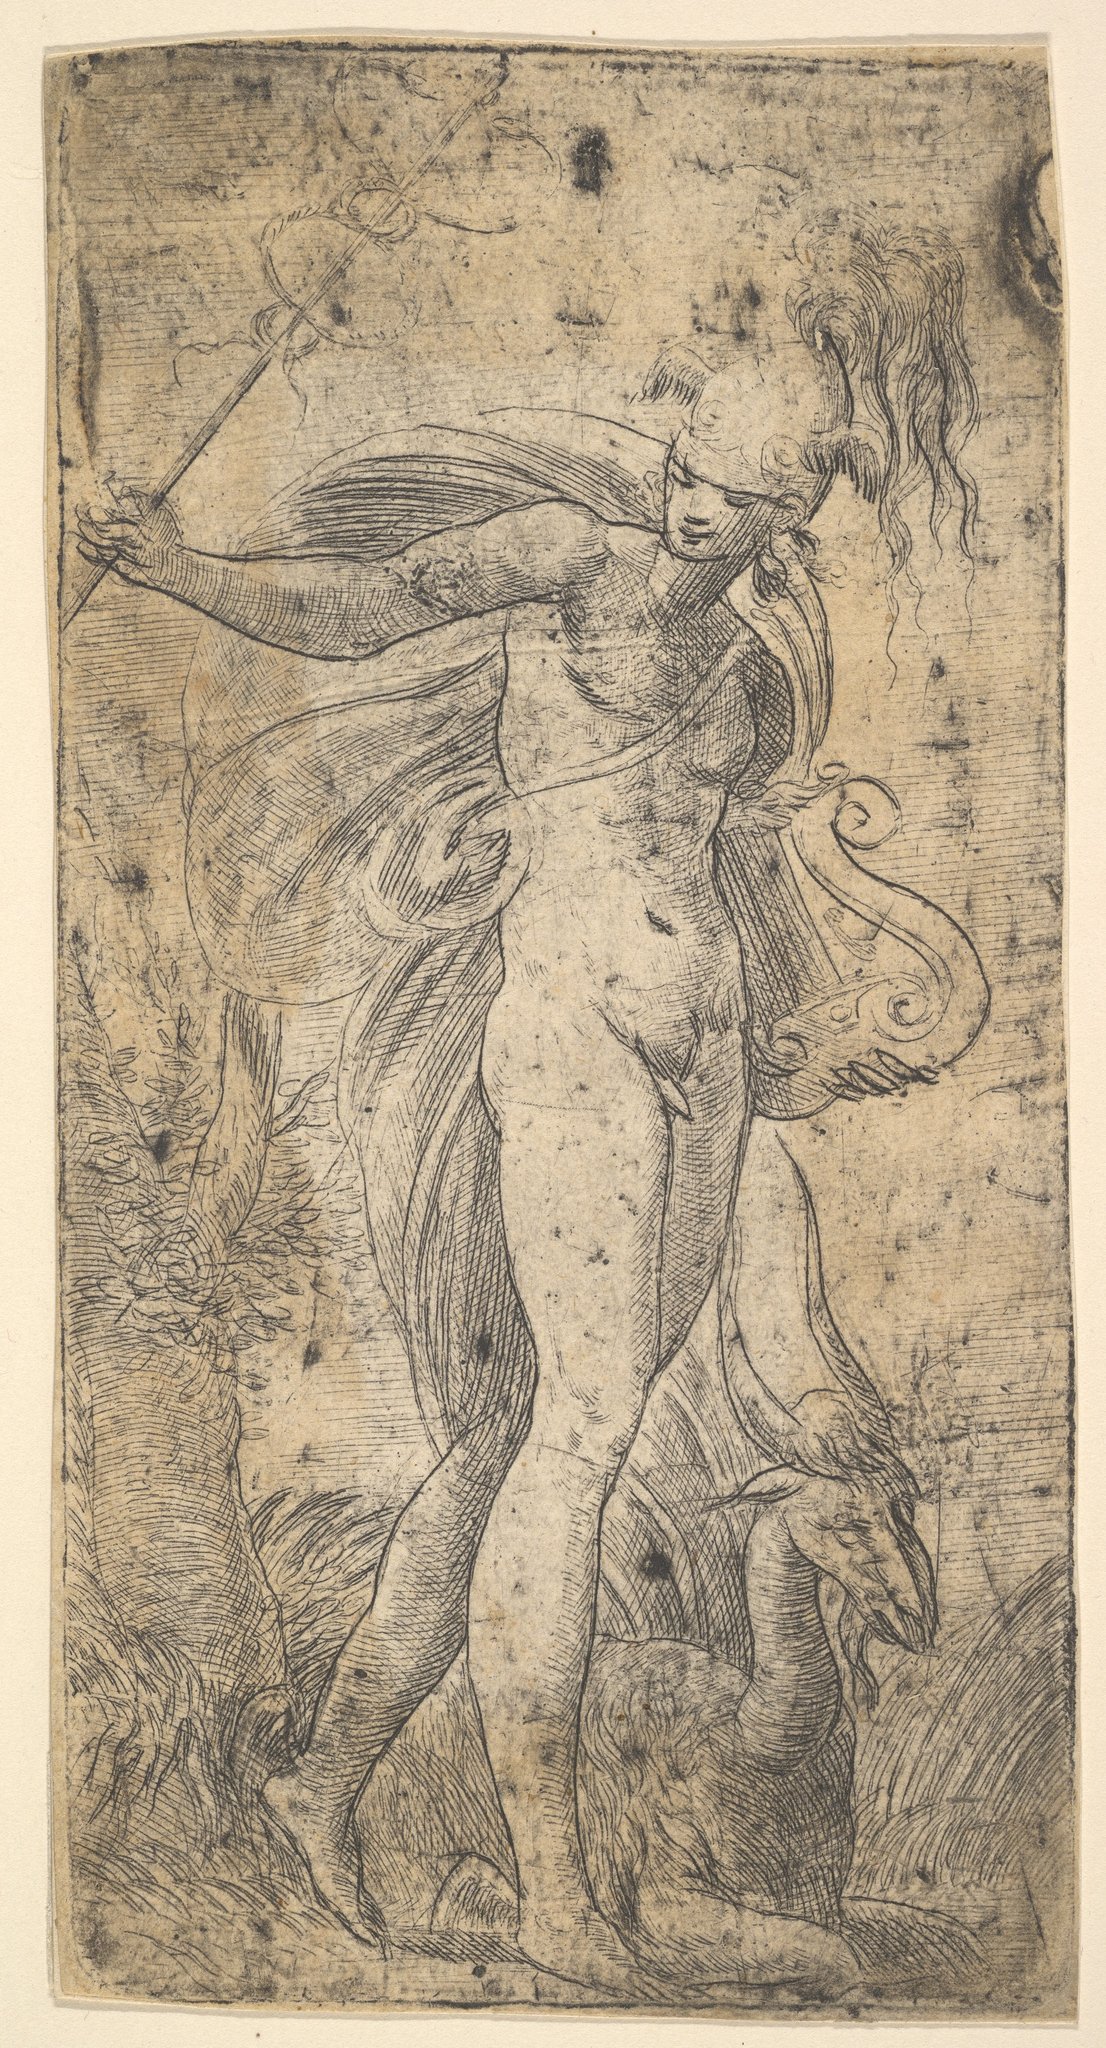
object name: print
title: Mercury standing holding a cadecus in his right hand, a lyre in his left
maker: andrea schiavone (andrea meldola)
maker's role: artist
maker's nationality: italian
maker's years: 1510-1563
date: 1536-1540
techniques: etching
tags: musical instruments,animals,mercury